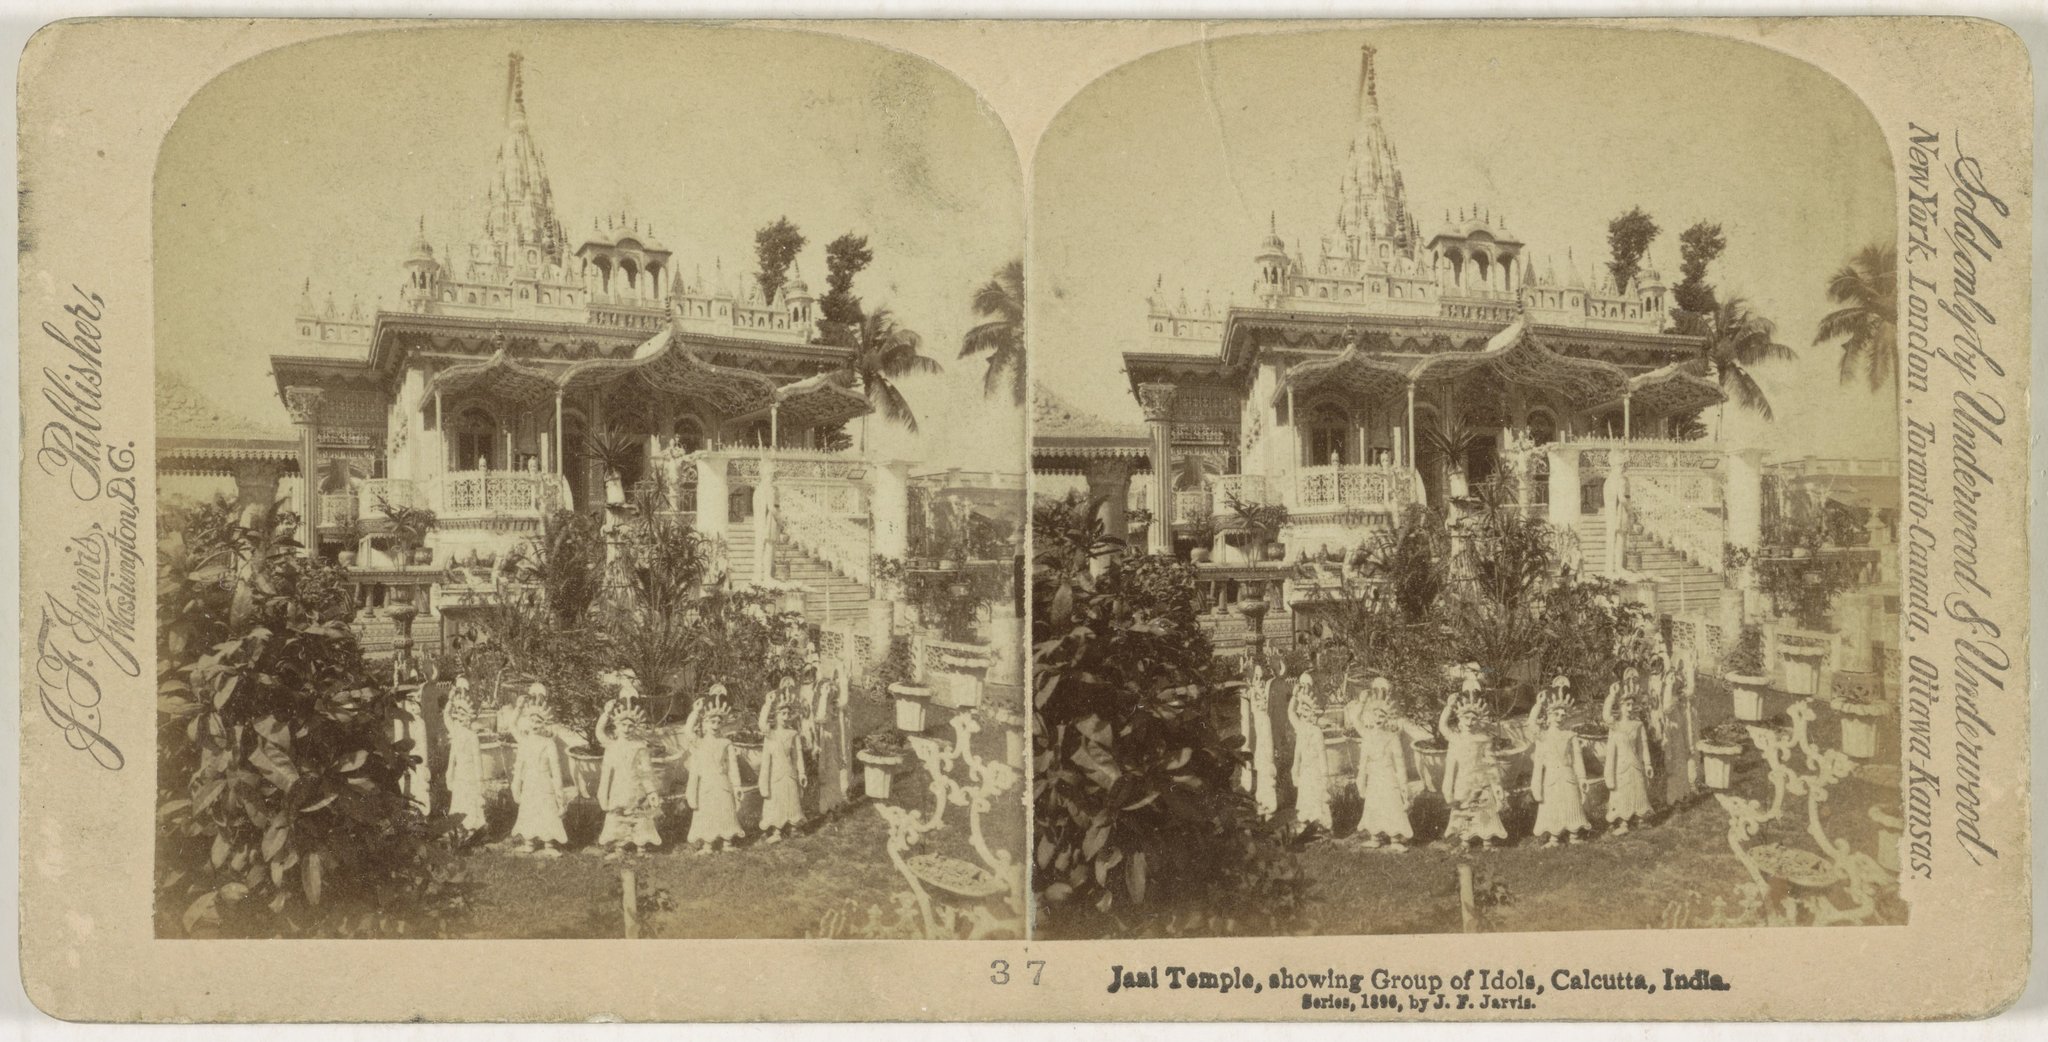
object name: stereograph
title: Jani Temple, showing group of Idols, Calcutta, India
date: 1896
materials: cardboard, paper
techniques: albumen print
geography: new york city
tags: temple, shrine ~ hinduism, buddhism, jainism, calcutta jain temple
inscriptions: inscription: ‘Series, 1899, by J. F. Jarvis.’, title: ‘Jani Temple, showing group of idols, Calcutta, India.’, number: ‘37’